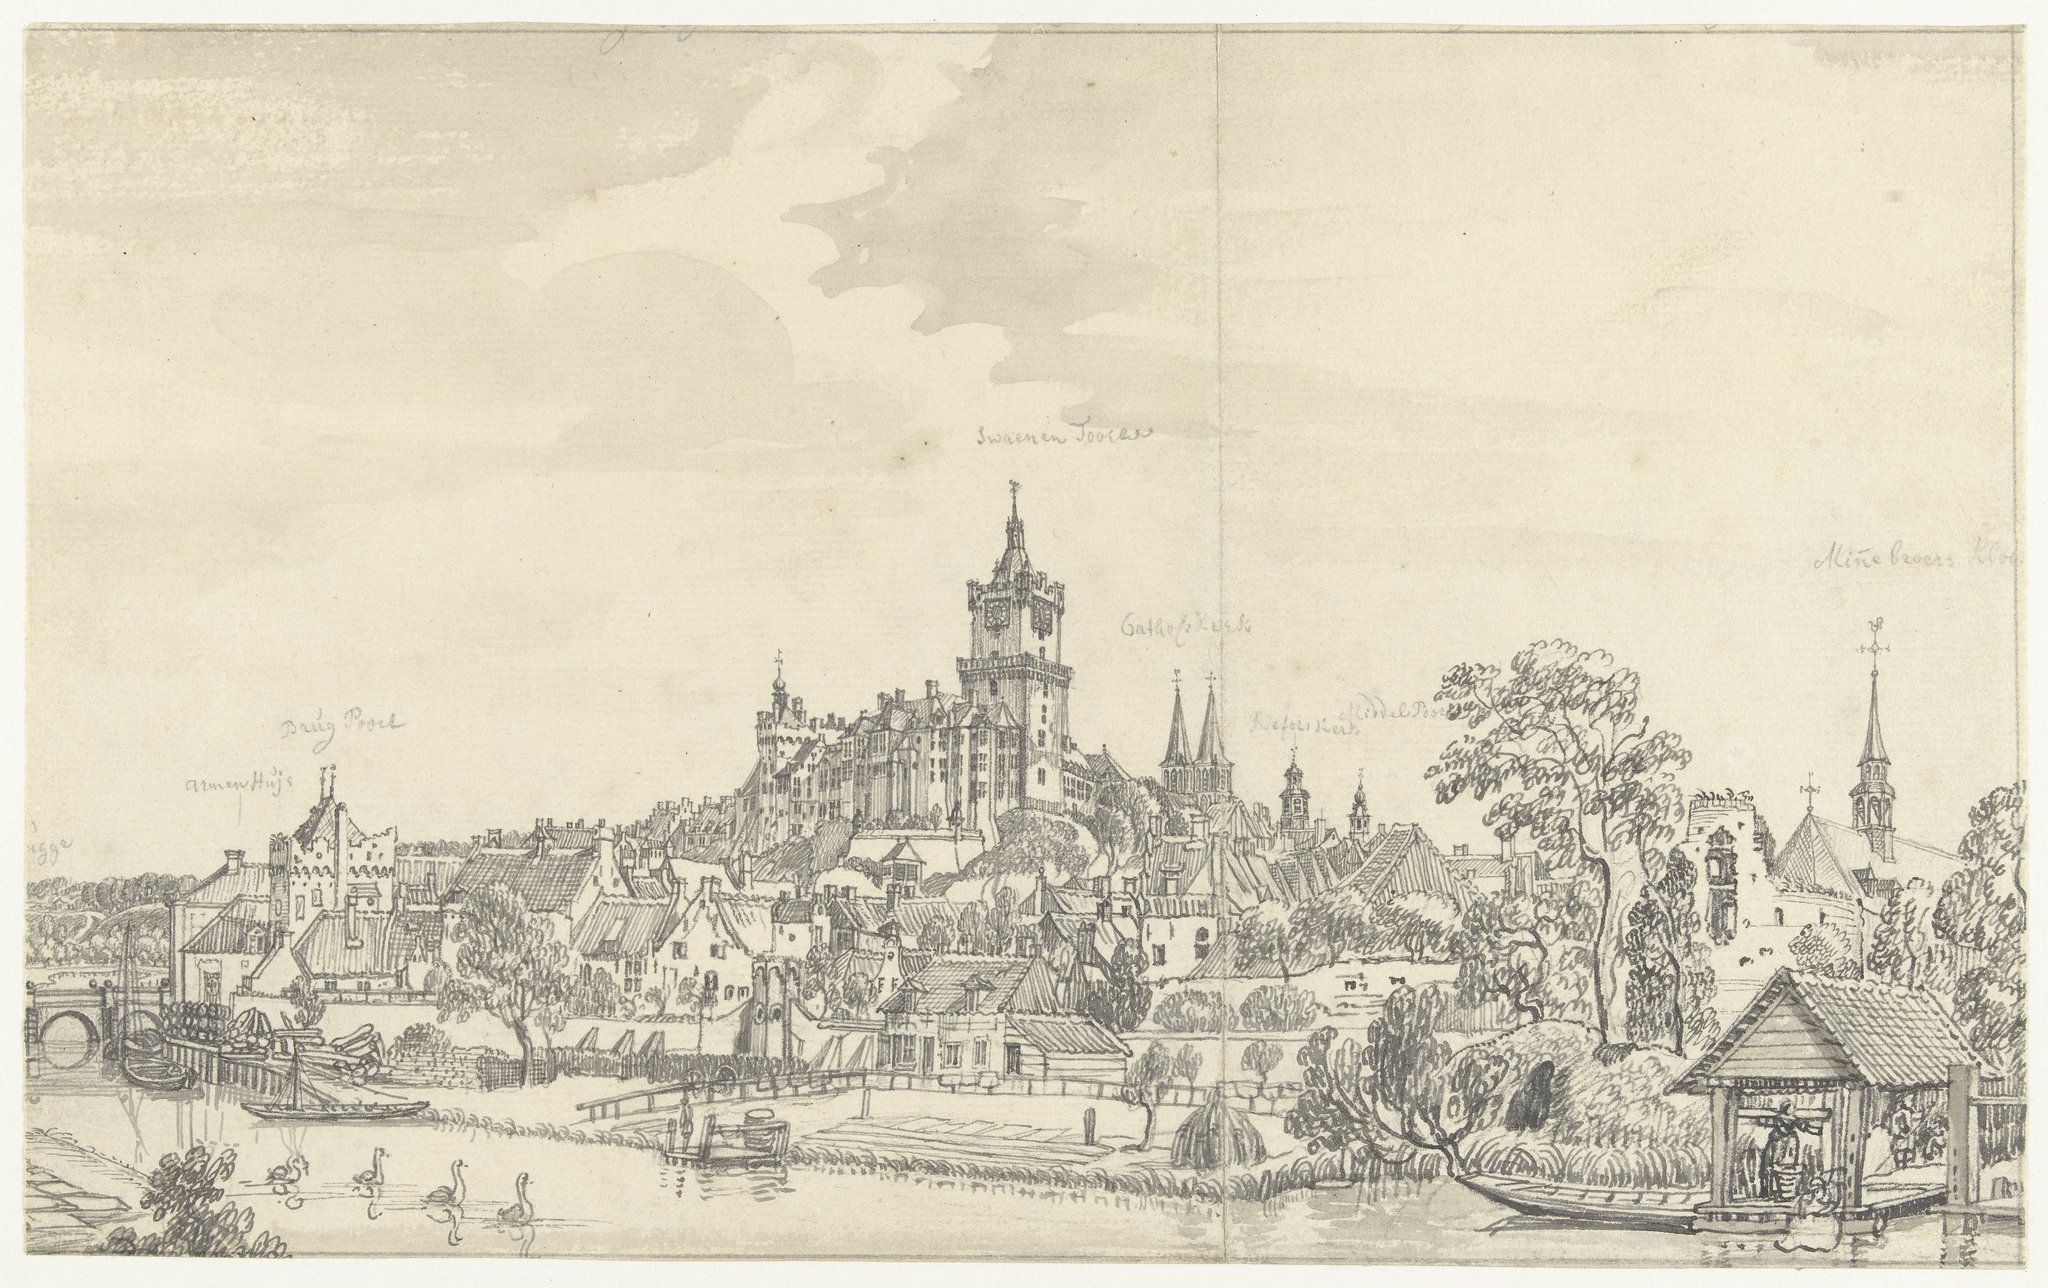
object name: drawing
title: Gezicht op Kleve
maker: jan de beijer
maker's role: draughtsman, print maker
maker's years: 1703-1780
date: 1745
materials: chalk, ink, paper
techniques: pen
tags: prospect of city, town panorama, silhouette of city, cleves